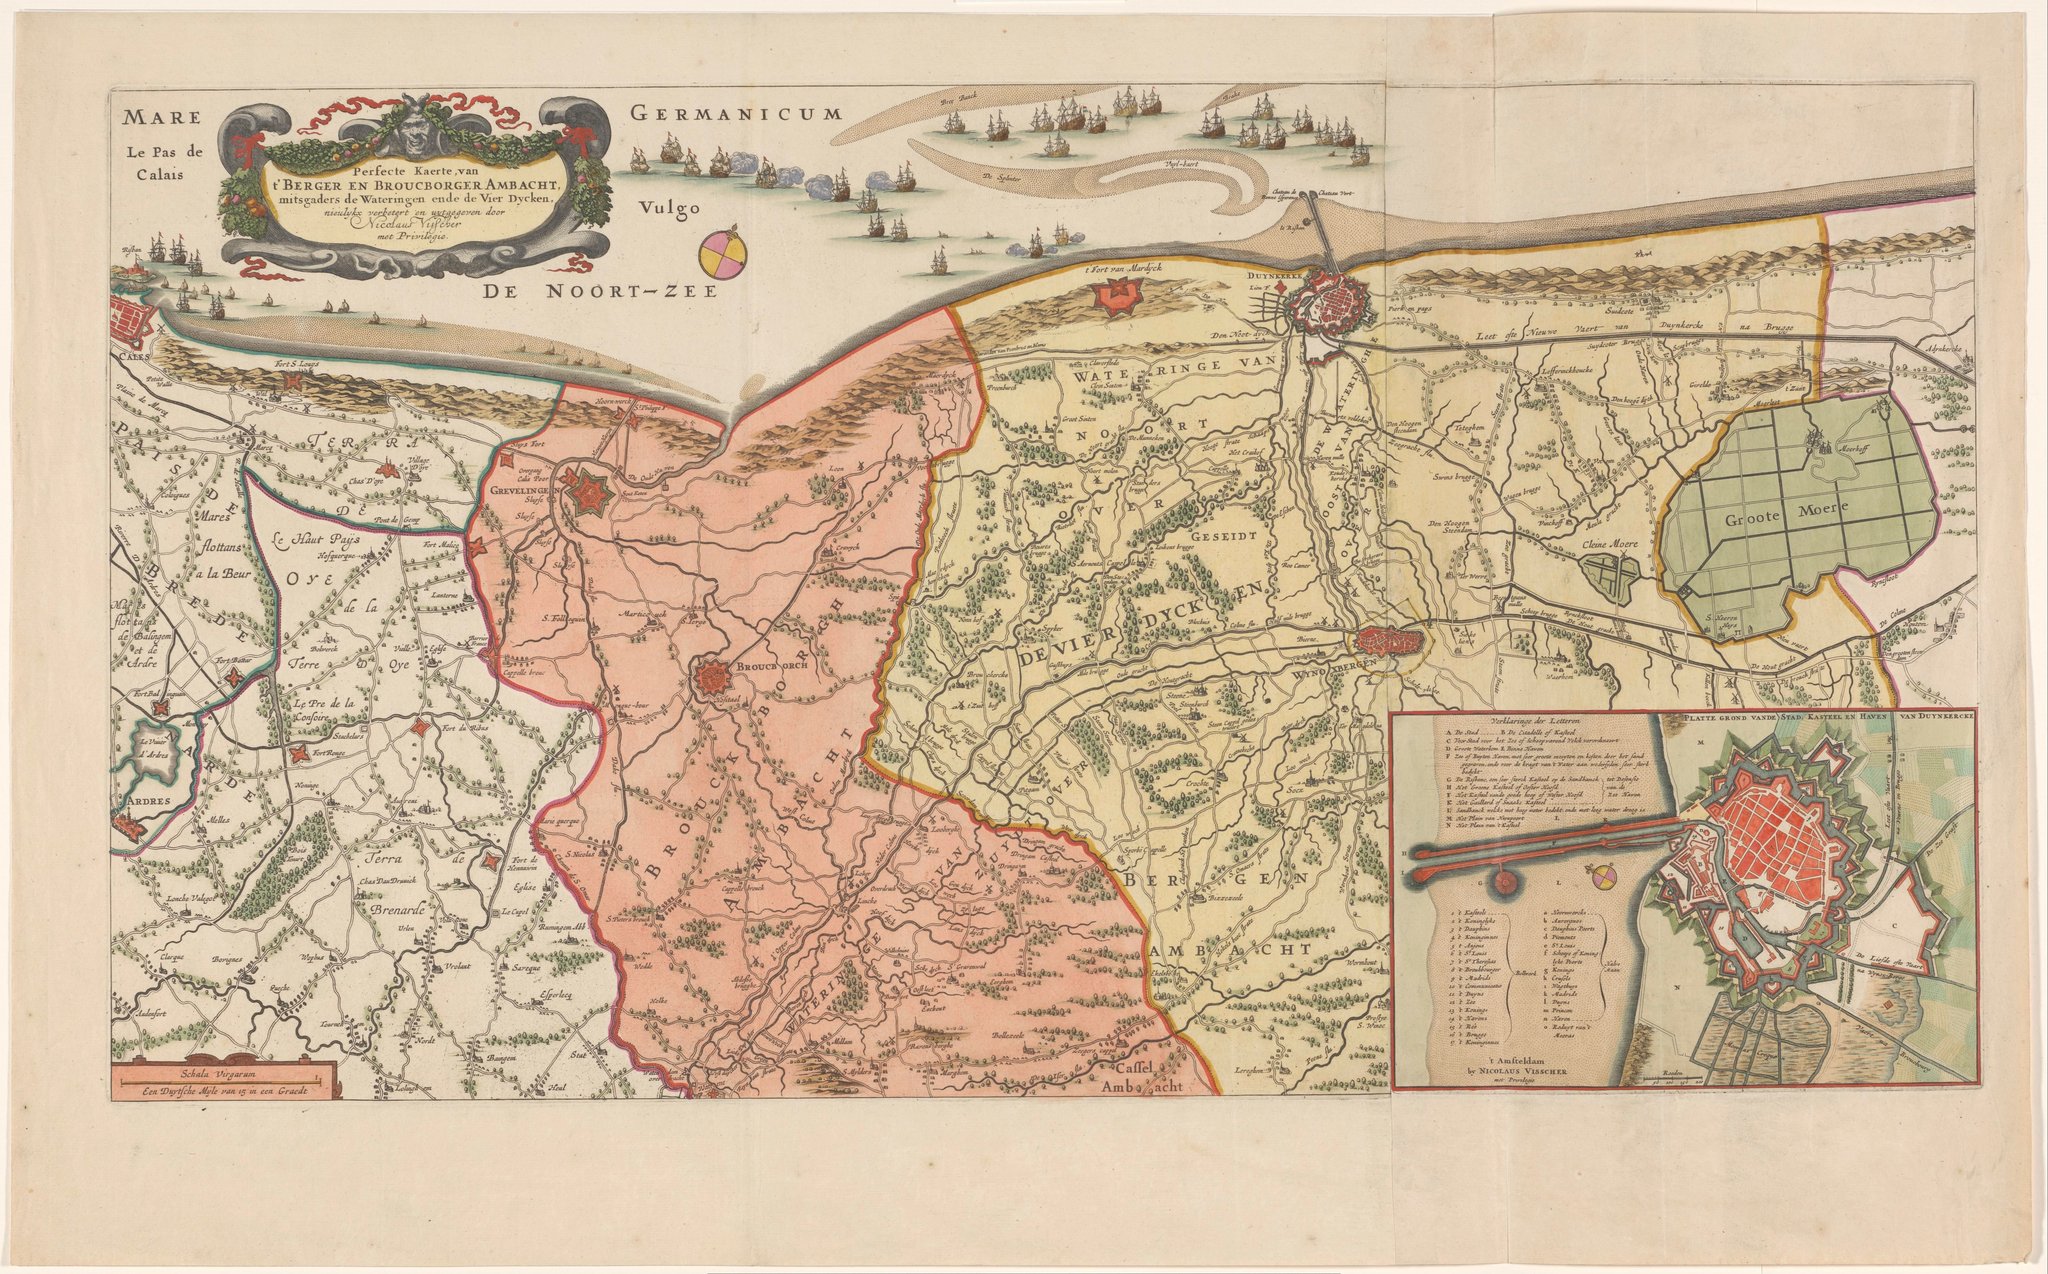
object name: print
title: Kaart van de kust van Frans-Vlaanderen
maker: Anonymous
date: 1677-1720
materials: paper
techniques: engraving, etching, hand coloring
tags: maps of separate countries or regions, maps of cities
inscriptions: collector's mark: Lugt 2228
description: Kaart van de kust van Frans-Vlaanderen. Linksboven de titelcartouche. Linksonder een cartouche met schaalstok: Een Duytsche Mijle van 15 in een Graedt. Rechtsonder een inzet met een plattegrond van Duinkerke, met links een legenda A-N, 1-17 en a-o. In de inzet onder, links van het midden, een schaalstok: 200 Roeden.